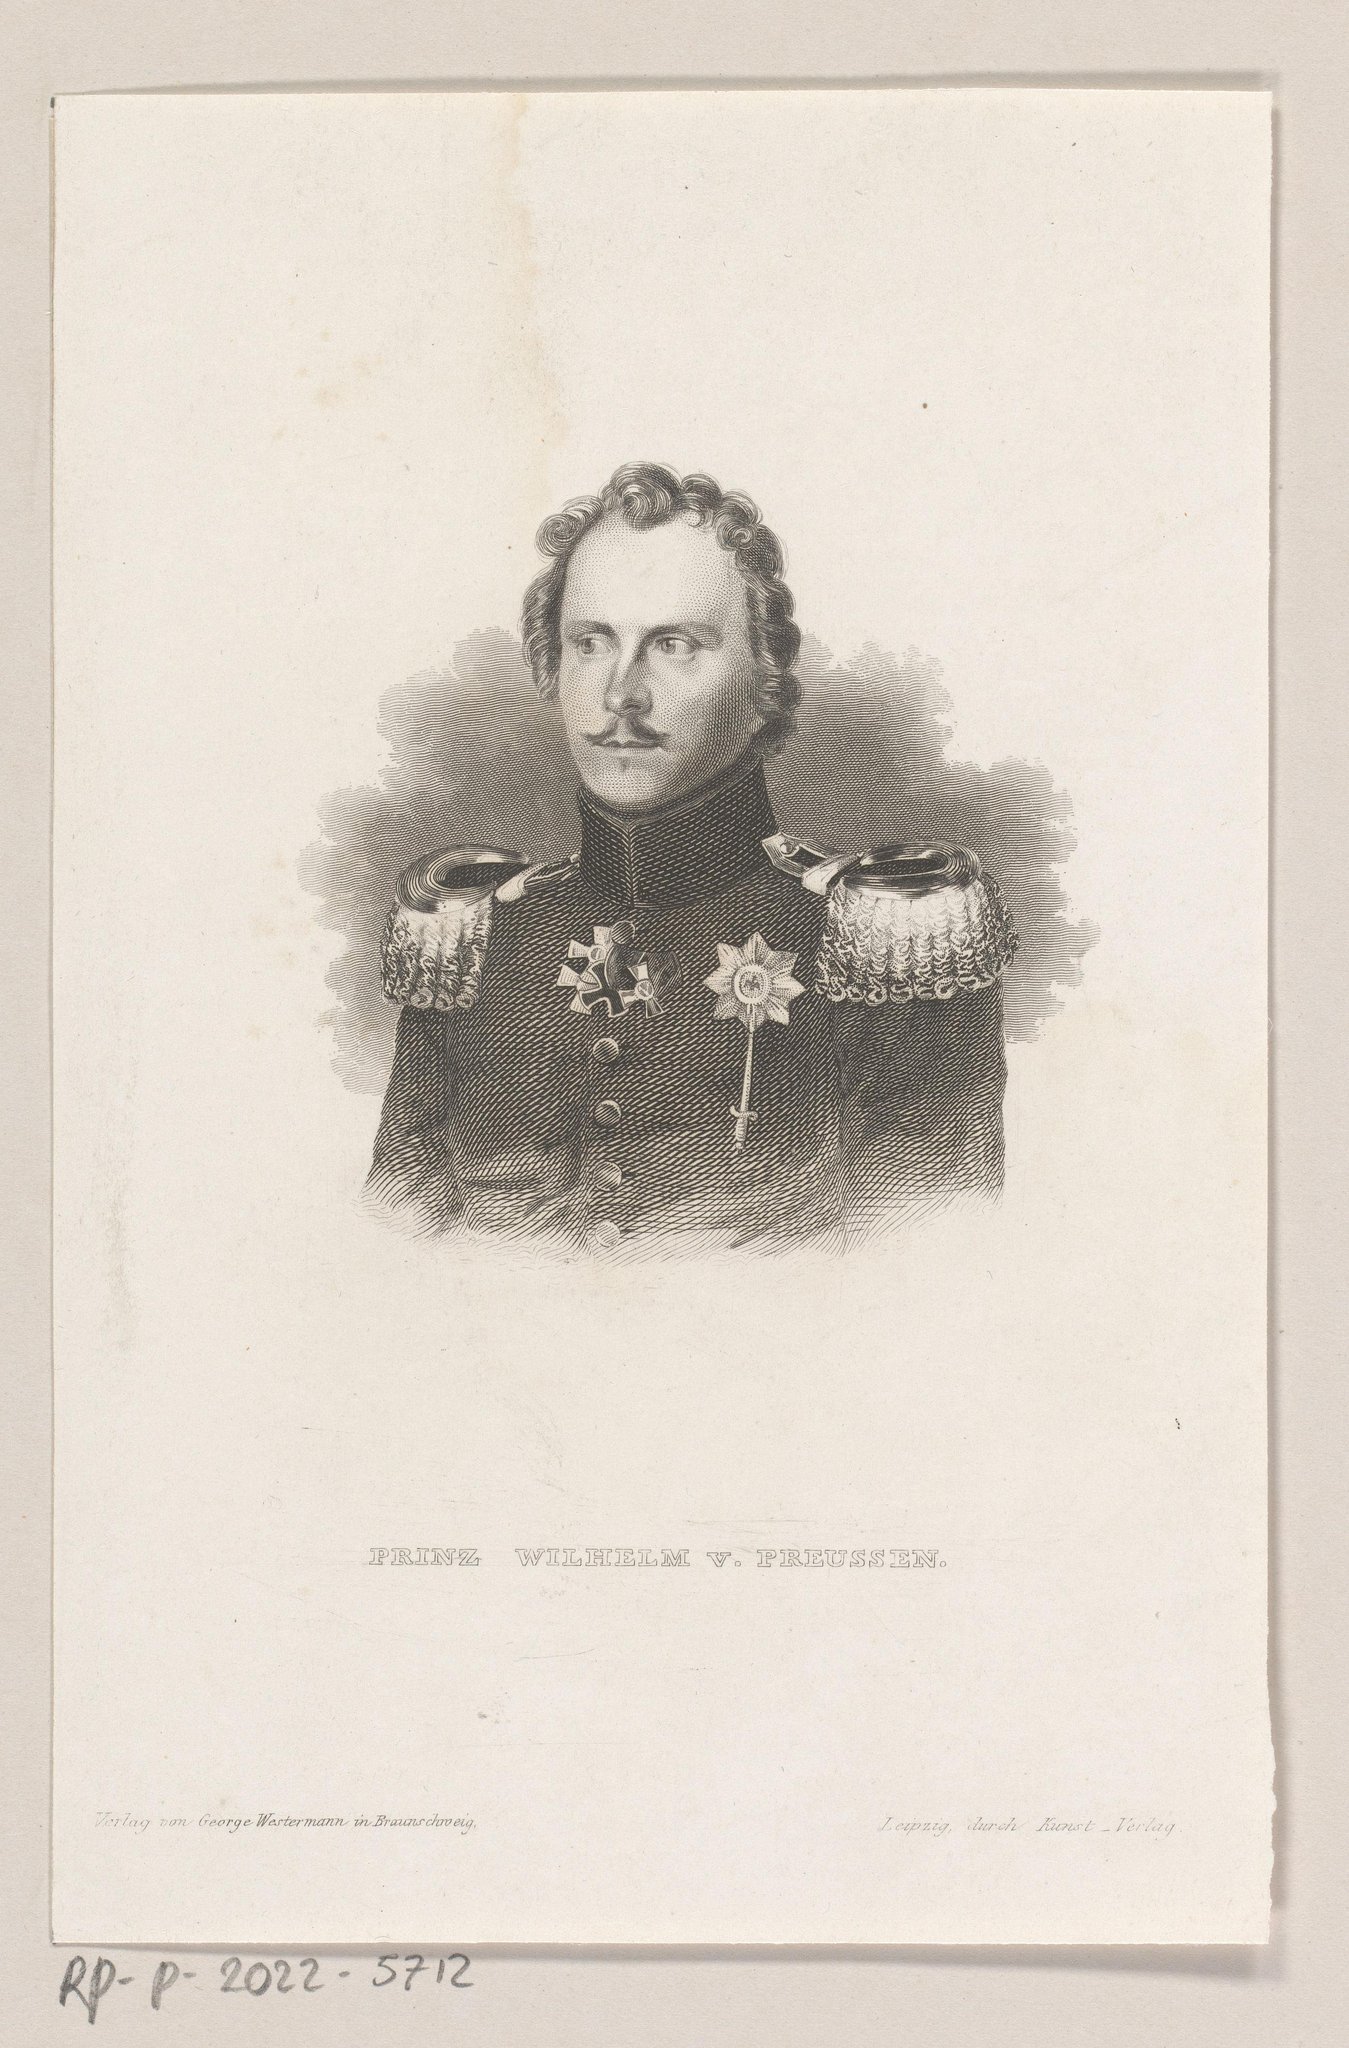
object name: print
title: Portret van Willem, prins van Pruisen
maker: Anonymous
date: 1841-1843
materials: paper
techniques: engraving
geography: germany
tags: berlin, historical persons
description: Prent waarschijnlijk uit: Sporschil, Johann. Geschichte der Zertrümmerung des Napoleonischen Heeres durch die Schlacht (...). Braunschweig: George Westermann, 1843, p. 200-201. Of mogelijk uit: Sporschil, Johann. Die große Chronik. Geschichte des Krieges des Verbündeten Europa’s gegen Napoleon Bonaparte in den Jahren 1813,1814 und 1815. Braunschweig: George Westermann, 1841, dl. 2.